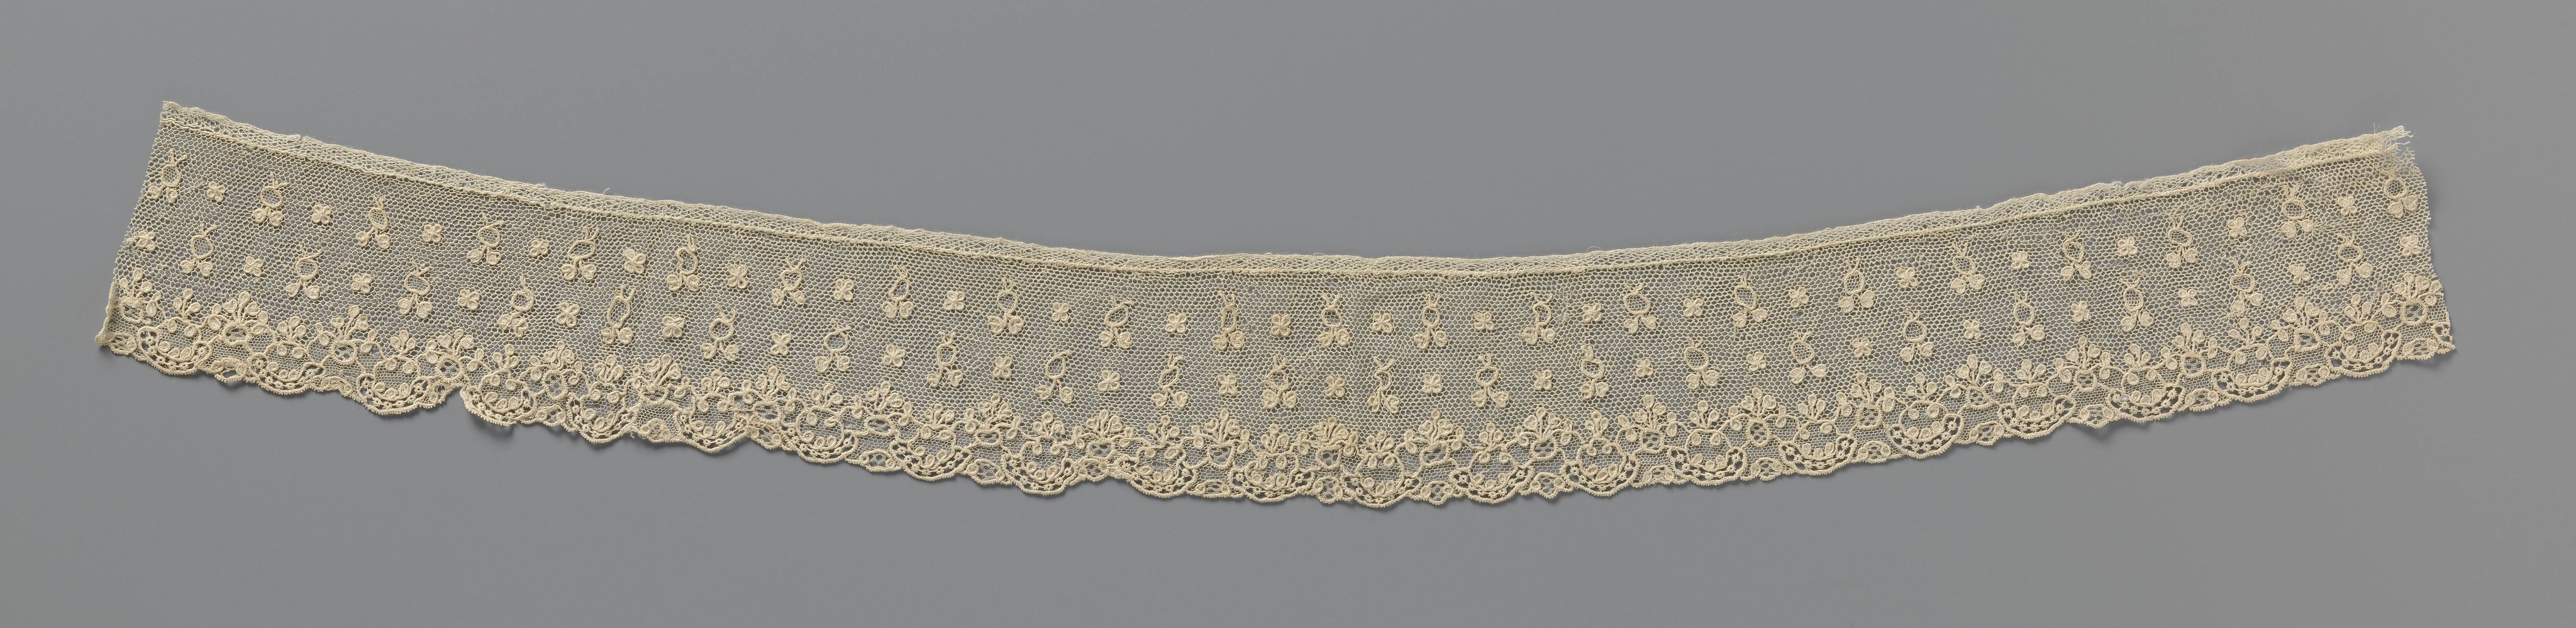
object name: strip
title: Strook naaldkant met bessen en cirkelvormen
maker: Anonymous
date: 1775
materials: linen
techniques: lace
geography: france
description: Strook naturelkleurige naaldkant: heren-Alençon. Strooimotief met twee rijen van afwisselend een bes of cirkel met twee blaadjes eronder en een klavertje vier. Het strooimotief staat op een fijne zeshoekige maasgrond. In de bessen een nuance door het toepassen van een fijnere zeshoekige maasgrond. Het patroon aan de onderzijde van de strook bestaat uit liggende boogjes waartussen en waarboven grotere en kleinere cirkelvormen. Uit de cirkelvormen ontspringen takjes met kleine hartvormige en ovale blaadjes. Volwerk zonder uitsparingen in de blaadjes. Siergrond met raderpicots in de boogjes en siergrond in de kleinere cirkels. Reliëf met gesloten festonsteken langs alle contouren. Flauwe schulpenrand aan de onderzijde. De bovenzijde is afgezet met een rand kloskant.